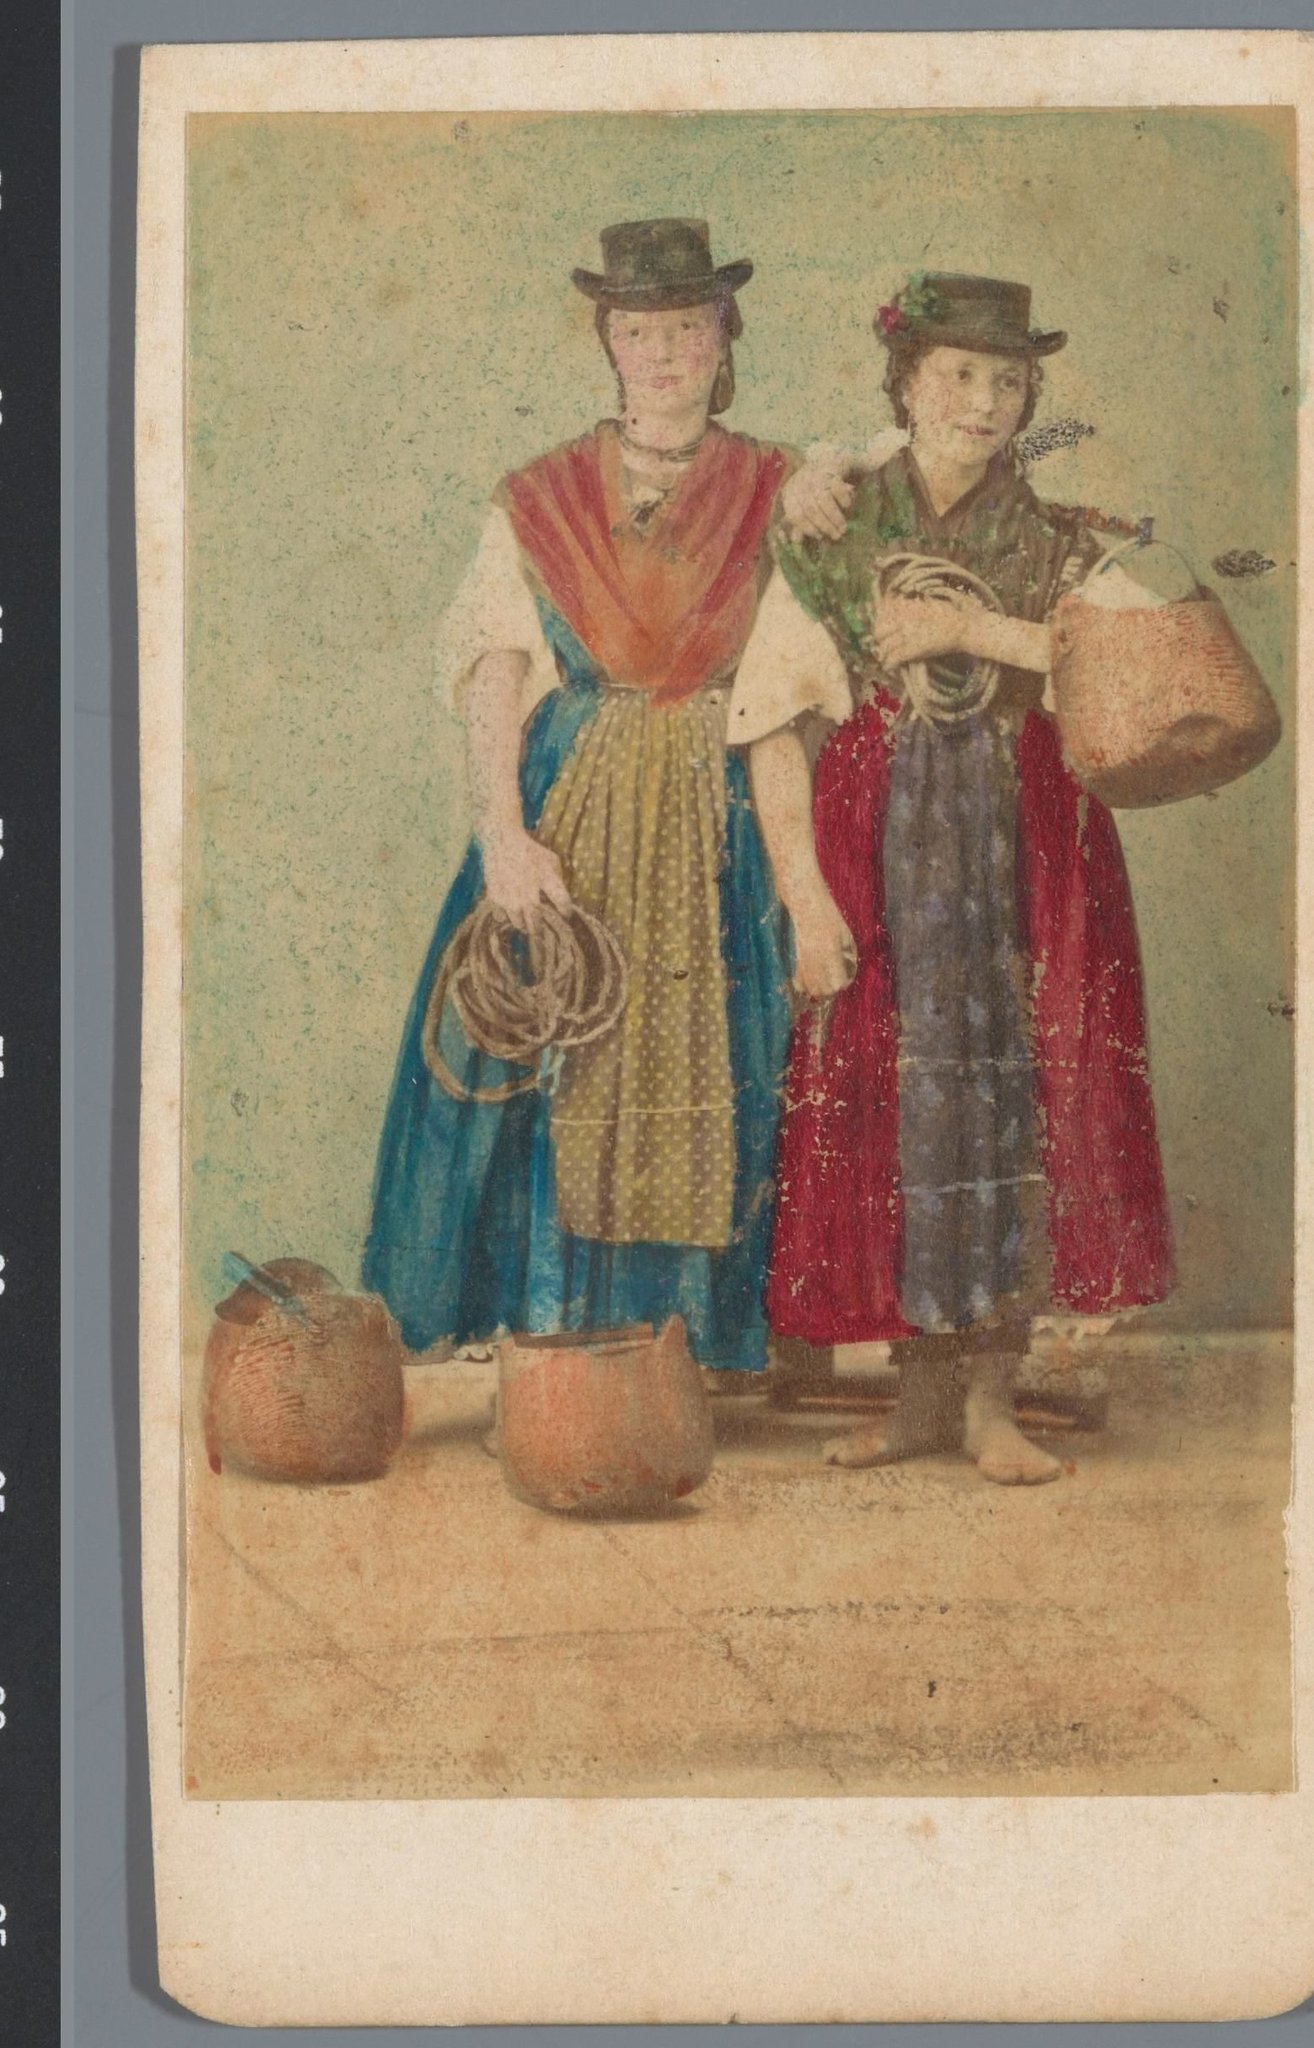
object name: carte de visite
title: Portret van twee onbekende vrouwen in lokale dracht met koperen wateremmers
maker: Anonymous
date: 1854-1885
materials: cardboard, paper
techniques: albumen print, hand coloring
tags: anonymous historical person portrayed, folk costume, regional costume, container of metal: bucket, can, canister, drum, tin